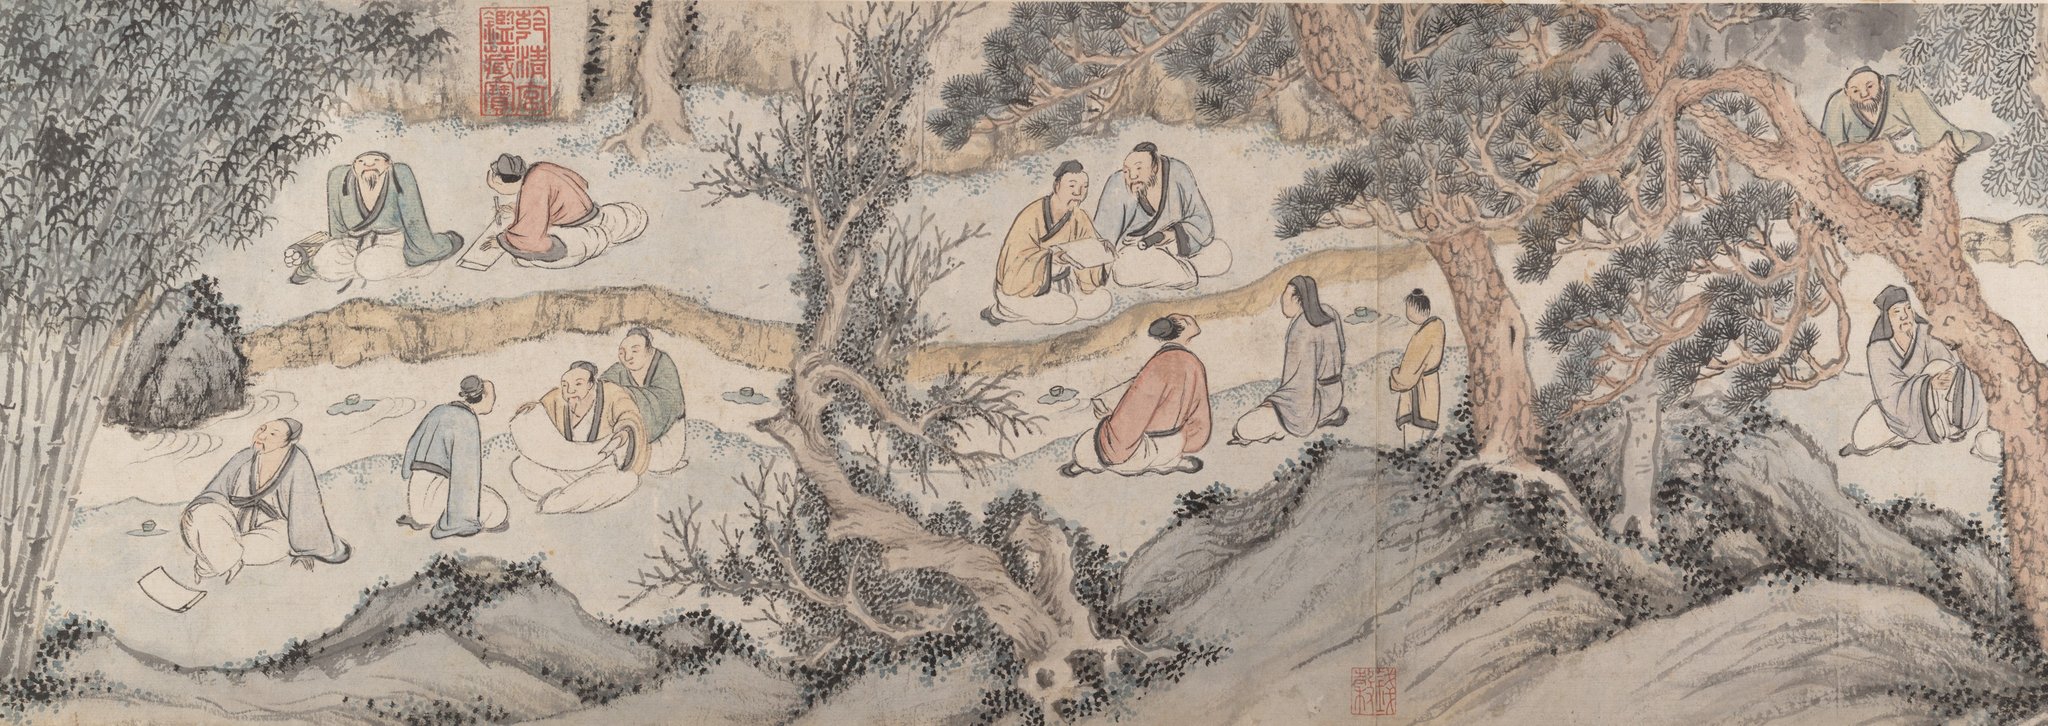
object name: handscroll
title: Gathering at the Orchid Pavilion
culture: chinese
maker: qian gu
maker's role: artist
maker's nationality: chinese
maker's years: 1508-1578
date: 1560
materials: ink, paper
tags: men,landscapes